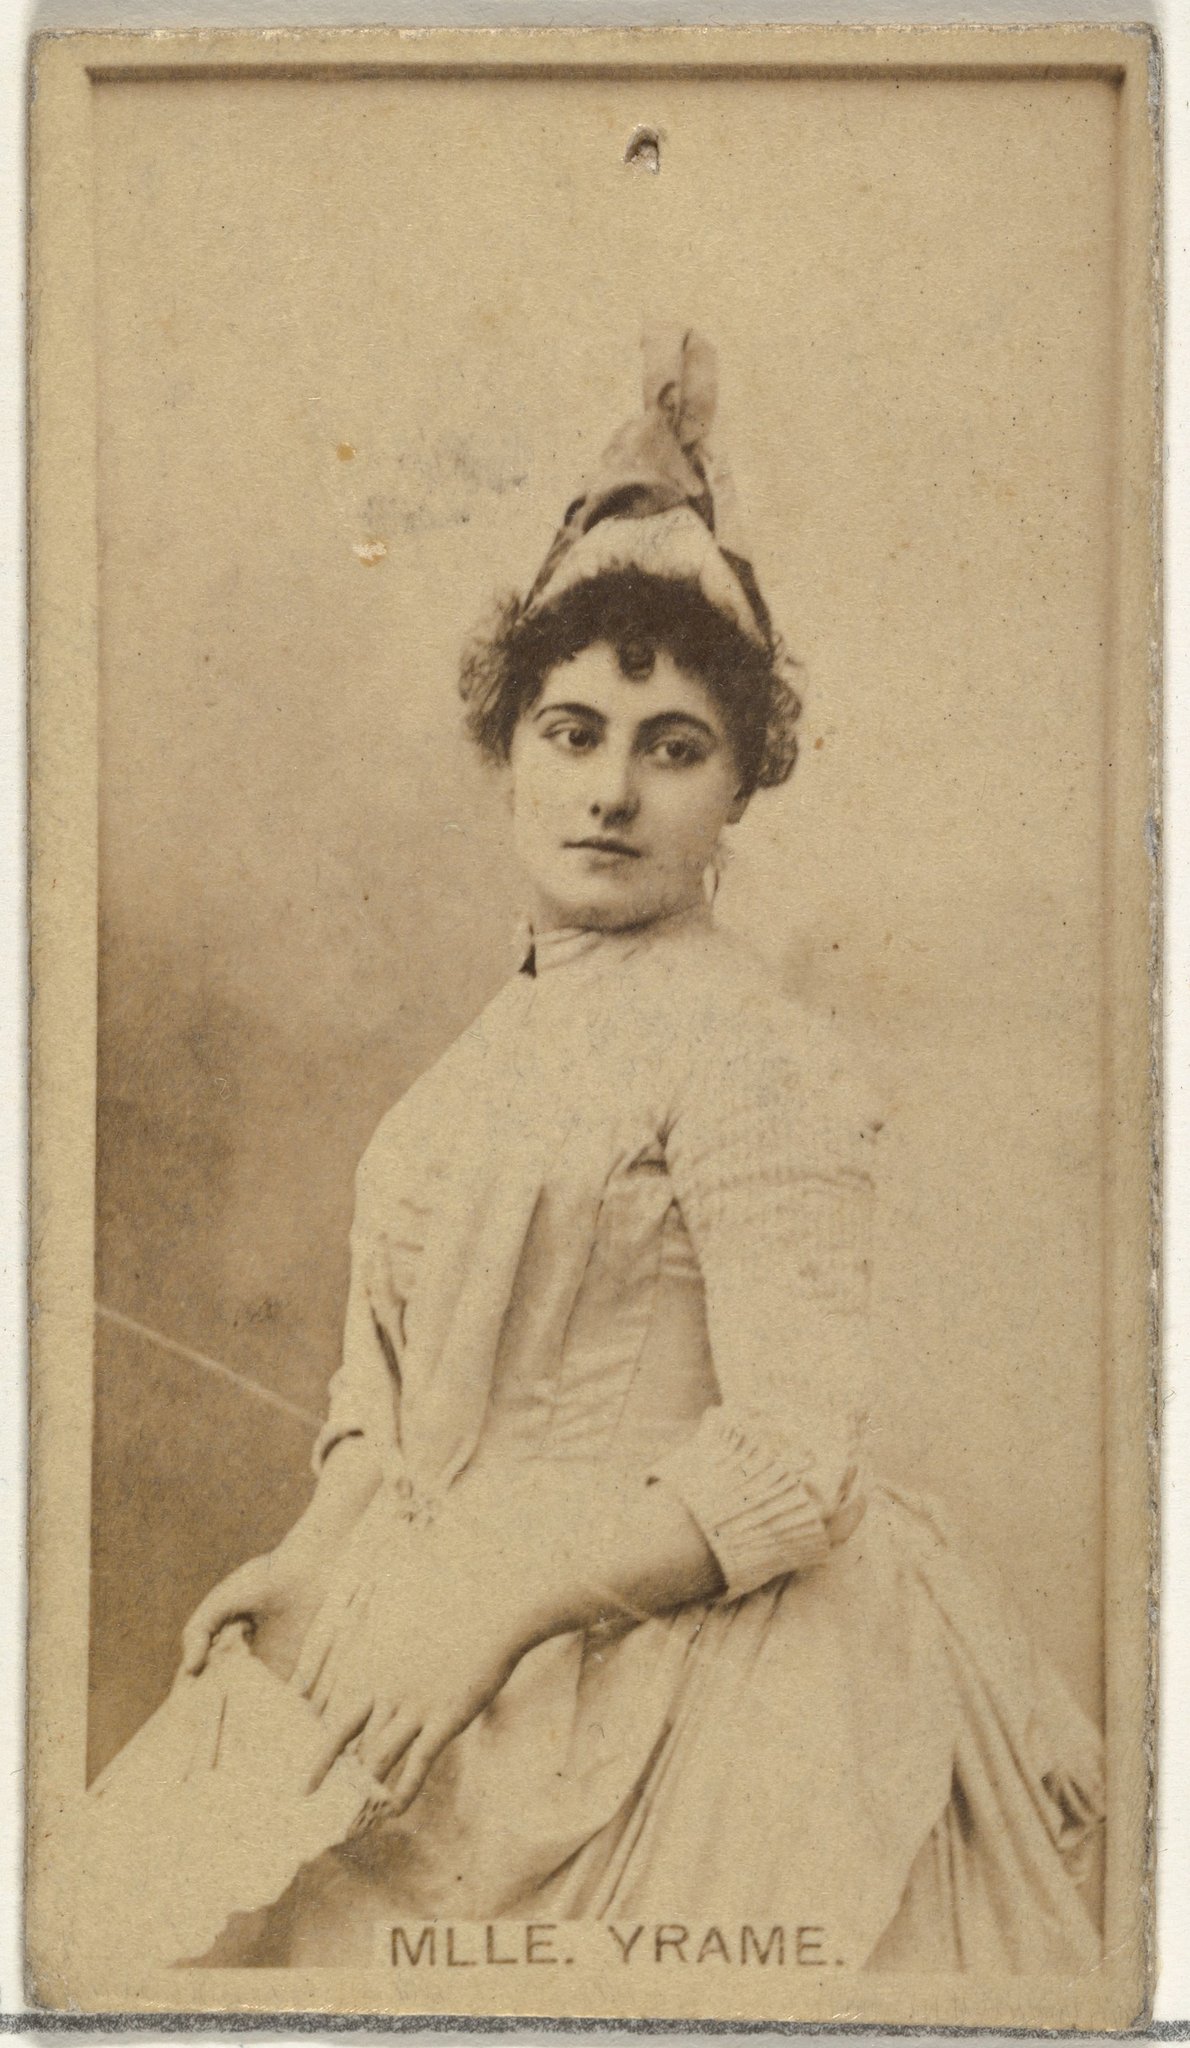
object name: photograph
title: Mlle. Yrame, from the Actors and Actresses series (N145-8) issued by Duke Sons & Co. to promote Duke Cigarettes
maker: w. duke, sons & co.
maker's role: publisher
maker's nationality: american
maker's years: 1870-1920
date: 1891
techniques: albumen silver print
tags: portraits,women,actresses